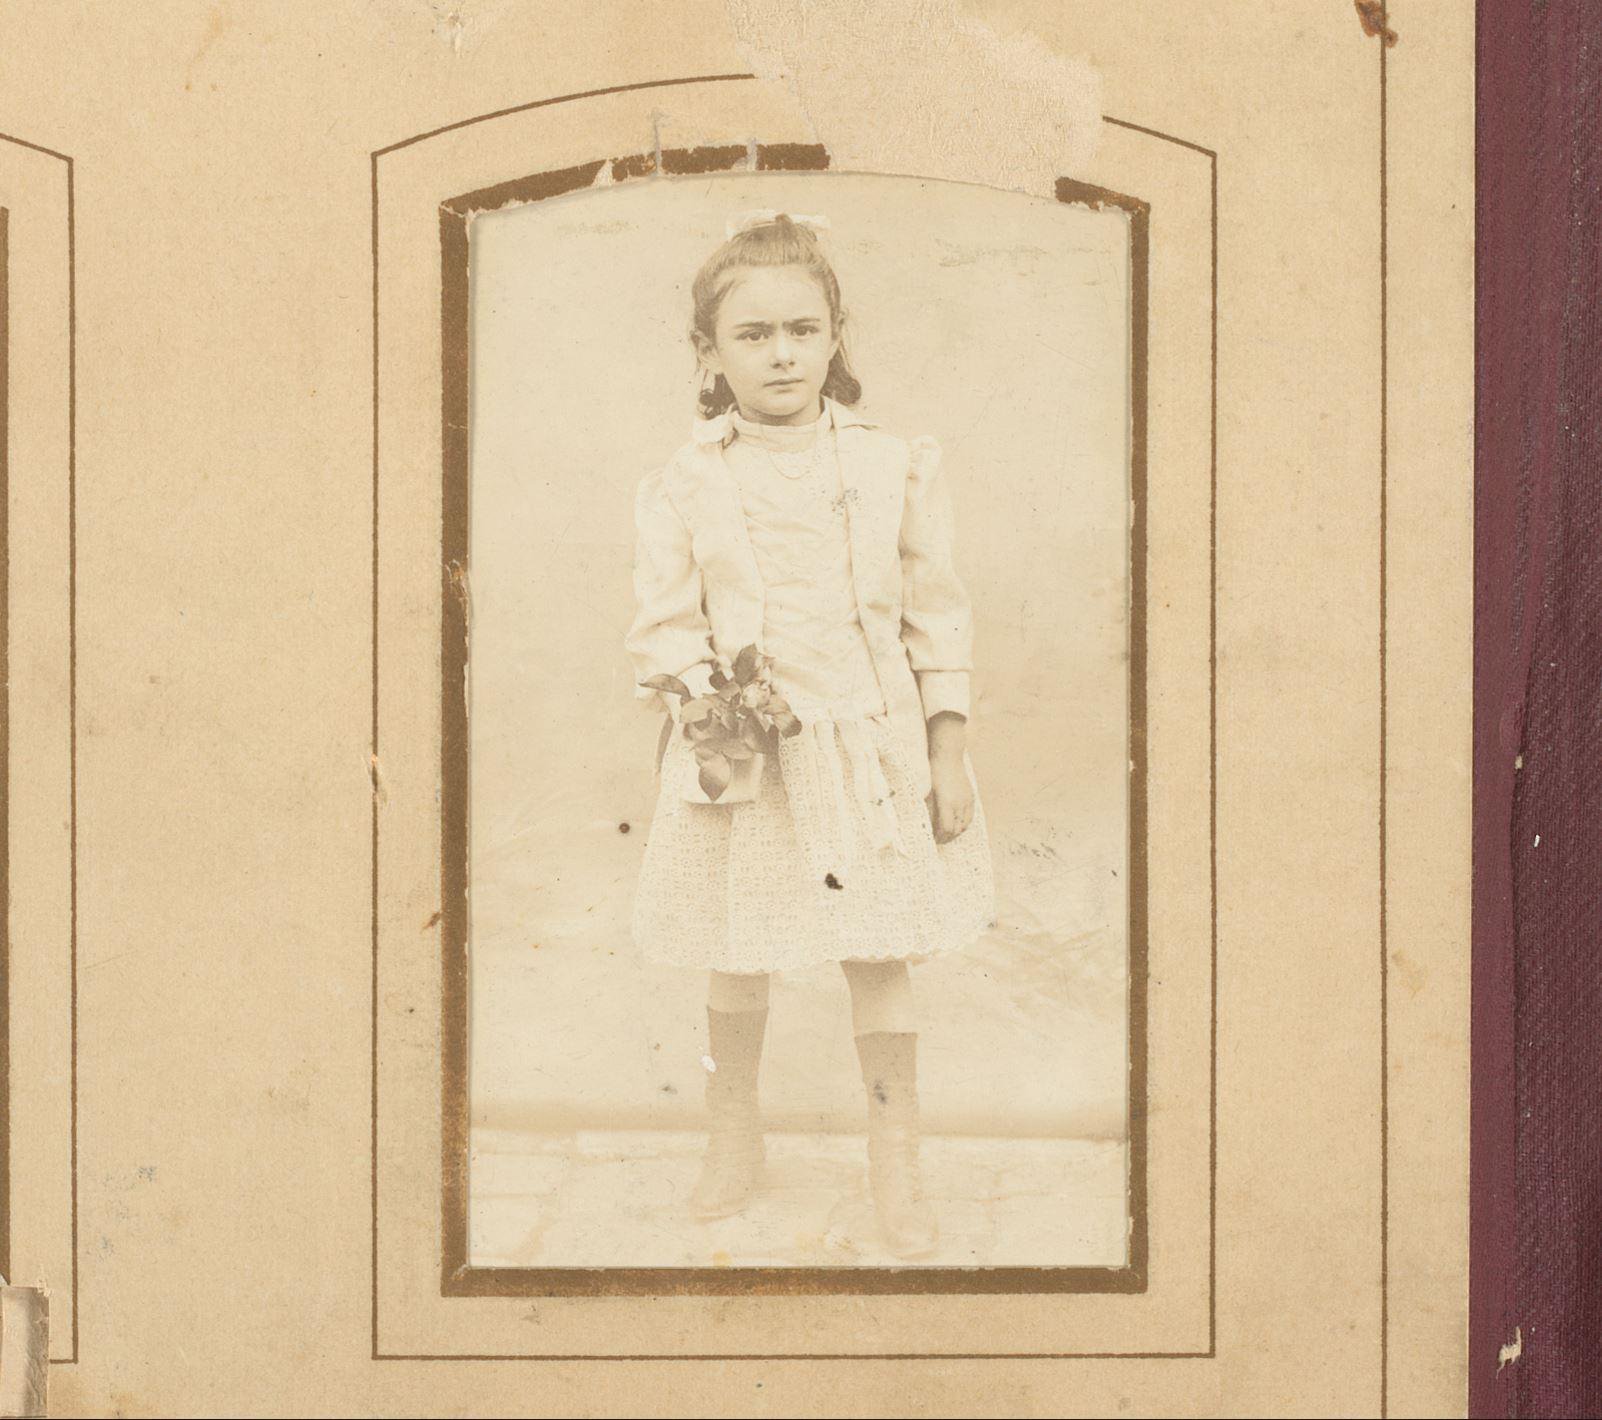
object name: album leaf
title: Portret van een meisje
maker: ajax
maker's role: fotograaf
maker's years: 1852-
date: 1880-1920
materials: cardboard, photographic support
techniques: collodion silver print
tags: girl (child between toddler and youth)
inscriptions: inscription: ‘Photographie des Communes/ Ajax/ 67, Route de Créteil, 67/ Alfort’, name: ‘[Agatha]’